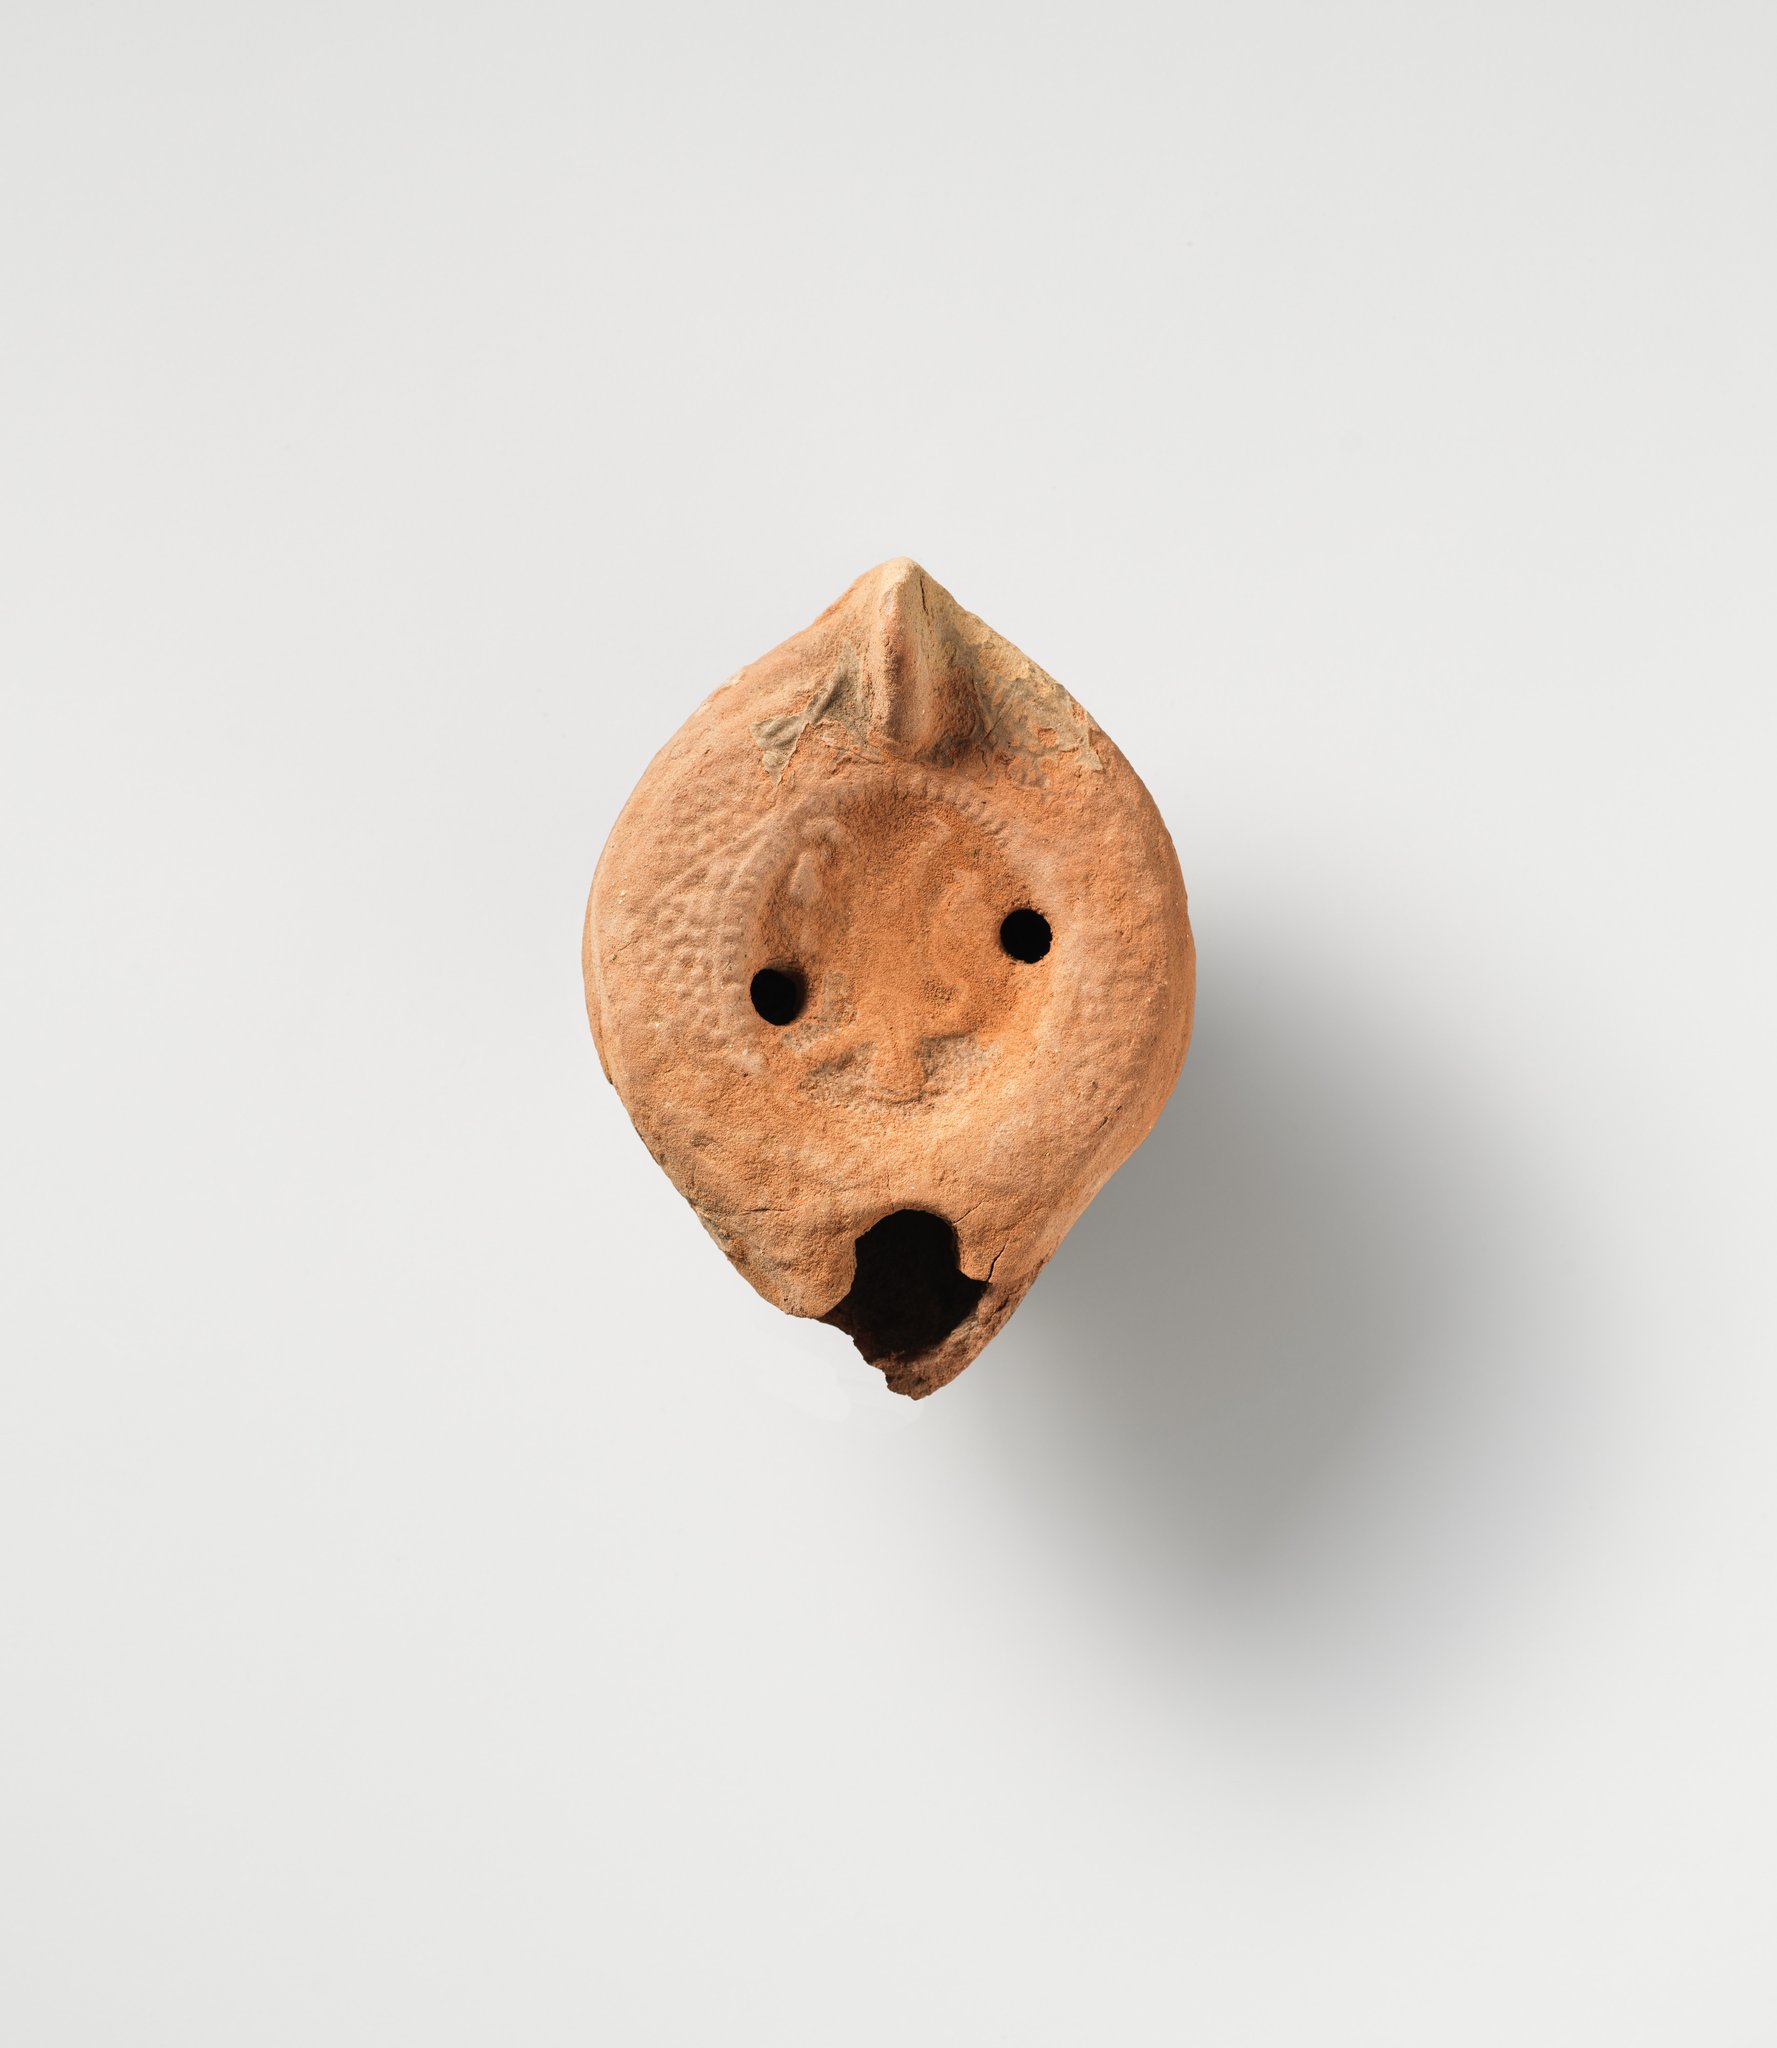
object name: lamp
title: Terracotta oil lamp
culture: roman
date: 301-500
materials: terracotta